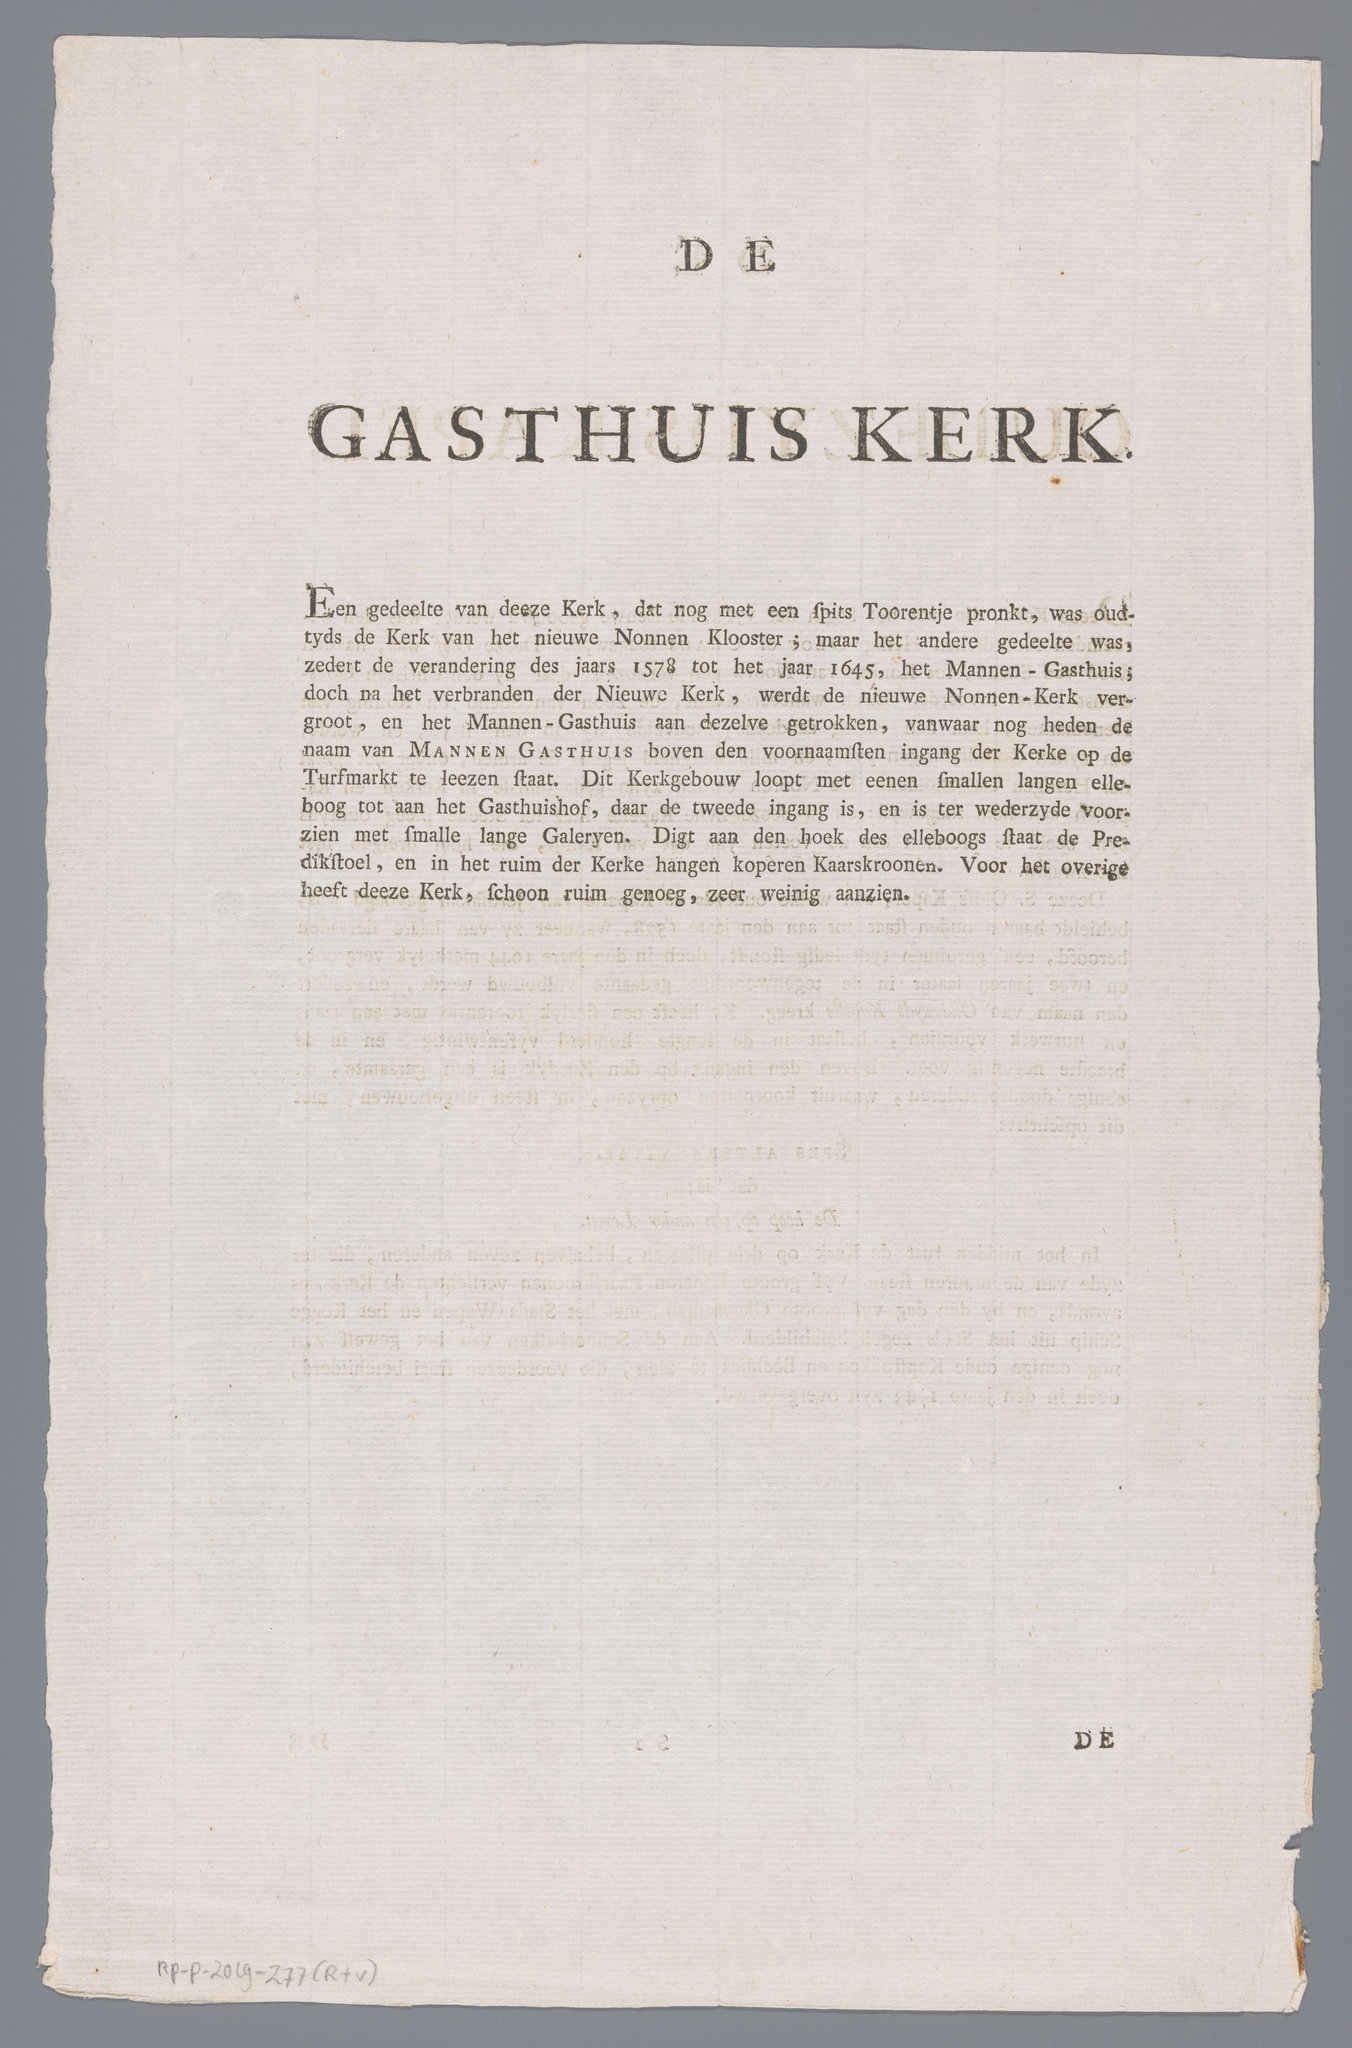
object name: text sheet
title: Beschrijving van de Gasthuiskerk te Amsterdam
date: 1783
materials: paper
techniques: letterpress printing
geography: netherlands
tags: gasthuiskerk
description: Tekstblad uit: Nieuwe atlas, van de voornaamste gebouwen en gezigten der stad Amsterdam, met derzelver beknopte beschryvingen. 2 dln. Amsterdam: Daniël Jean Changuion en Petrus den Hengst [in opdracht van Pierre Fouquet], 1783.